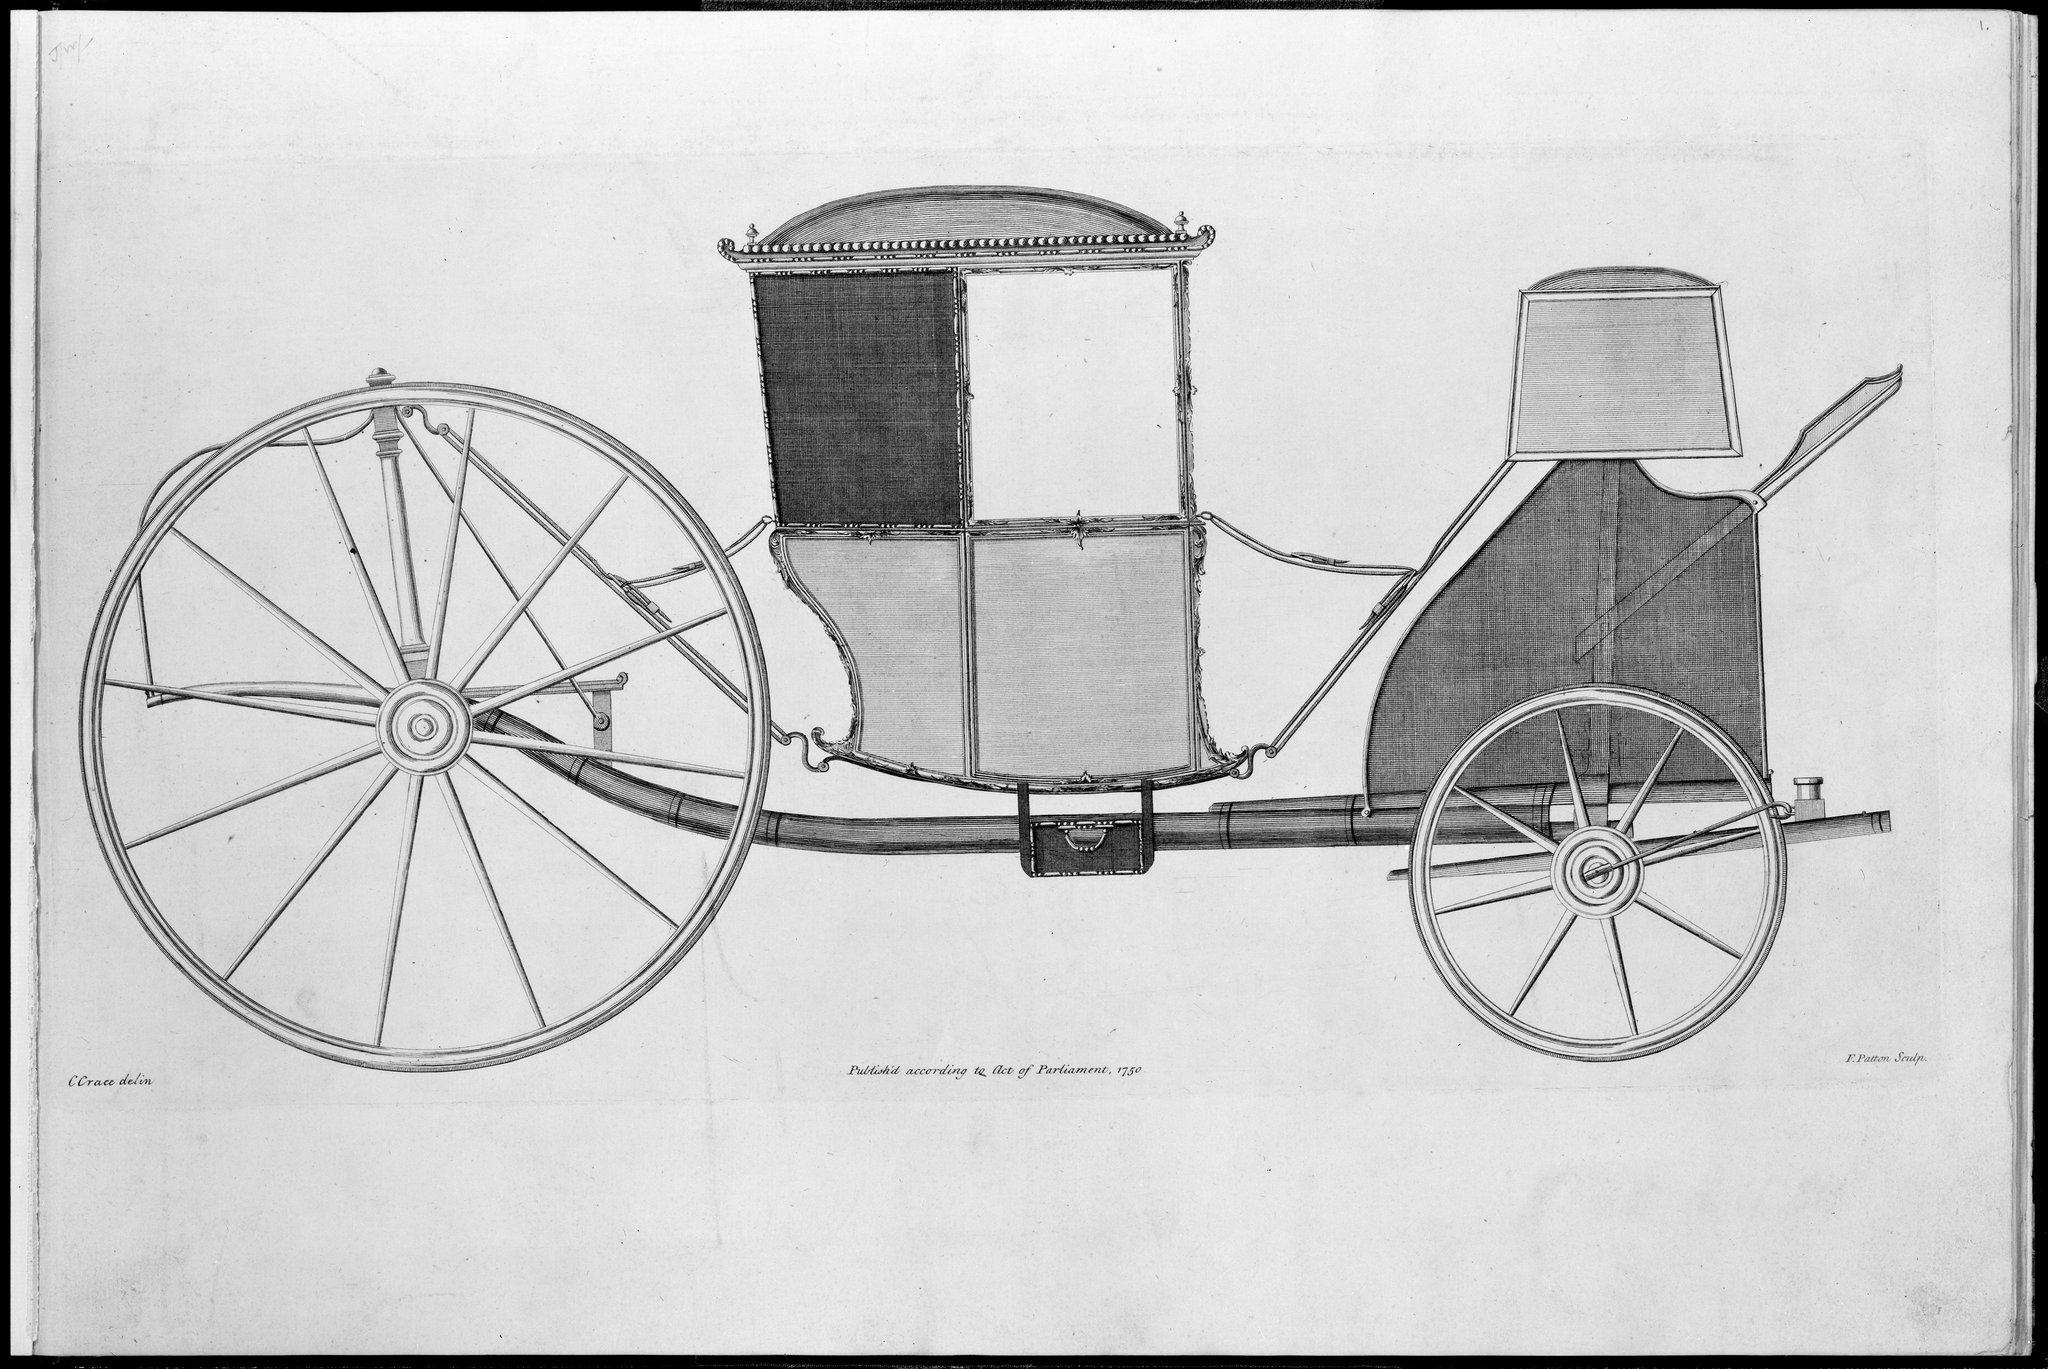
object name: book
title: Carriages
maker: charles crace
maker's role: designer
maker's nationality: british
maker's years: 1727-1784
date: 1750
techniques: engraving, etching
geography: england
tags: carriages